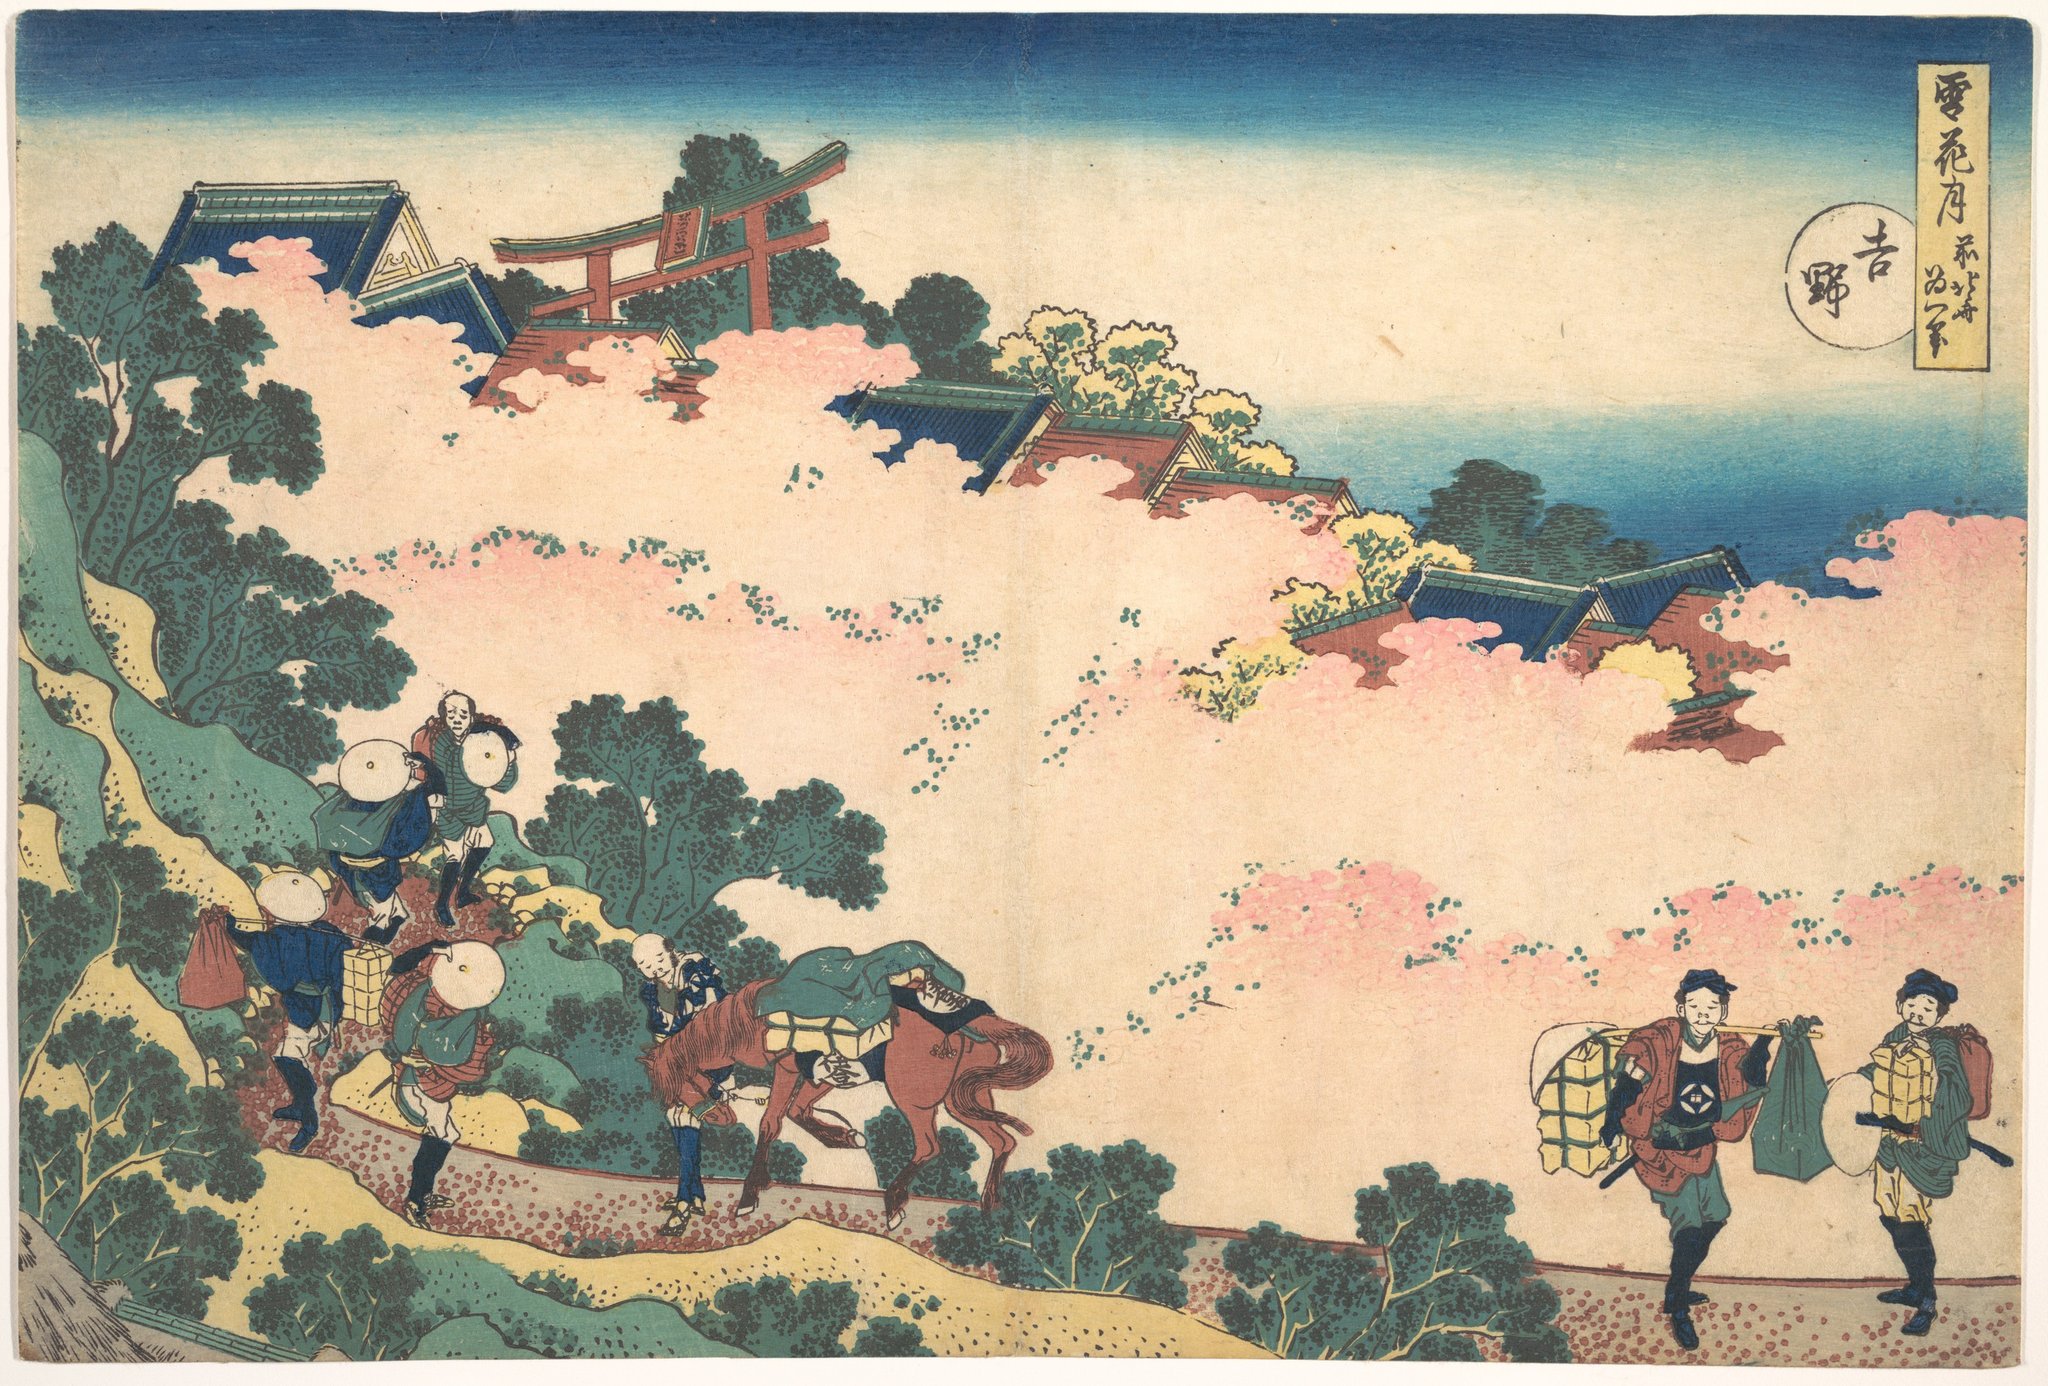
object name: woodblock print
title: Cherry Blossoms at Yoshino (Yoshino), from the series Snow, Moon, and Flowers (Setsugekka)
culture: japanese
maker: katsushika hokusai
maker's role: artist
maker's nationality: japanese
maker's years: 1760-1849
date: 1833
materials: ink, paper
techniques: woodblock print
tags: men,horses,trees